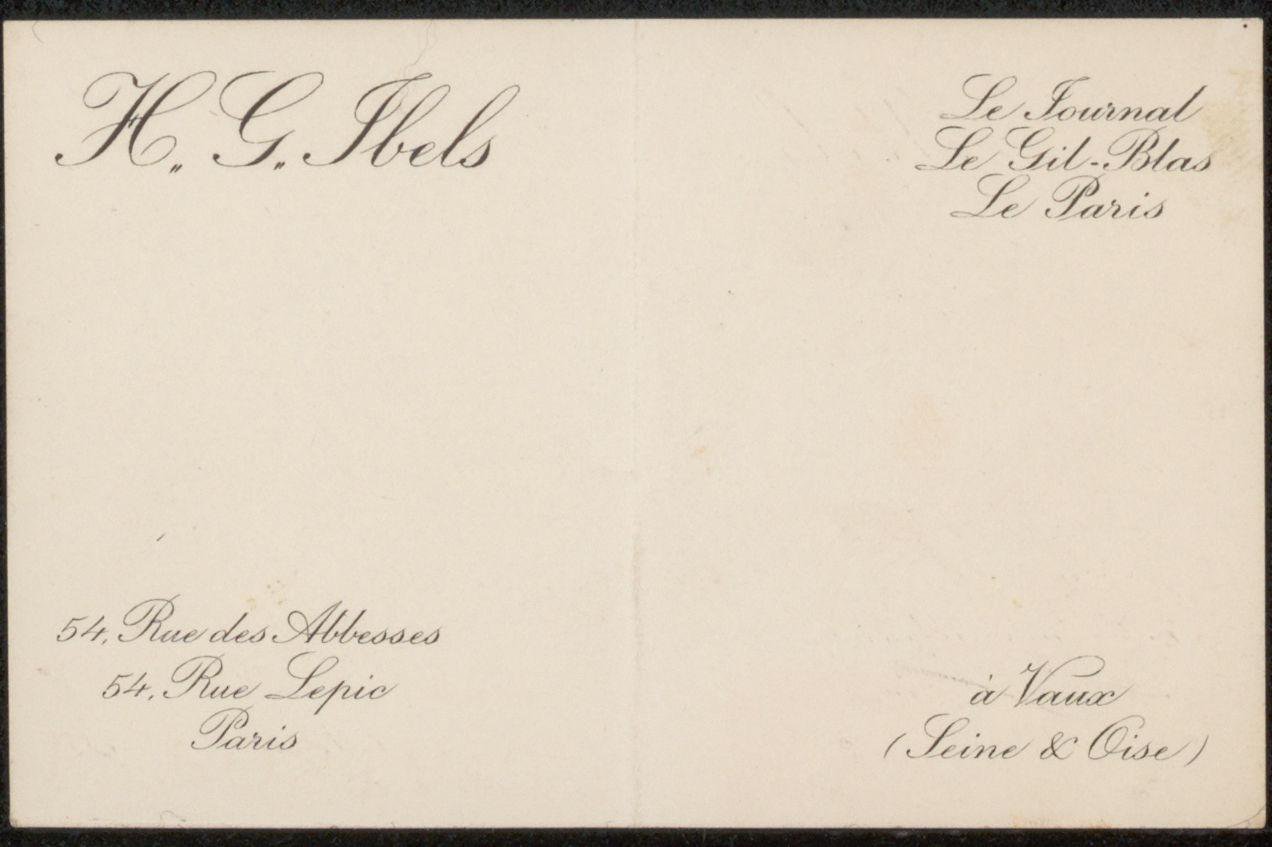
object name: visiting card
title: Visitekaartje aan Philip Zilcken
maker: henri gabriel ibels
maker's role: print maker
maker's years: 1867-1936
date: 1877-1930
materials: cardboard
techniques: printing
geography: paris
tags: the hague, painter, draughtsman, philip zilcken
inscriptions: collector's mark: ‘RPK’